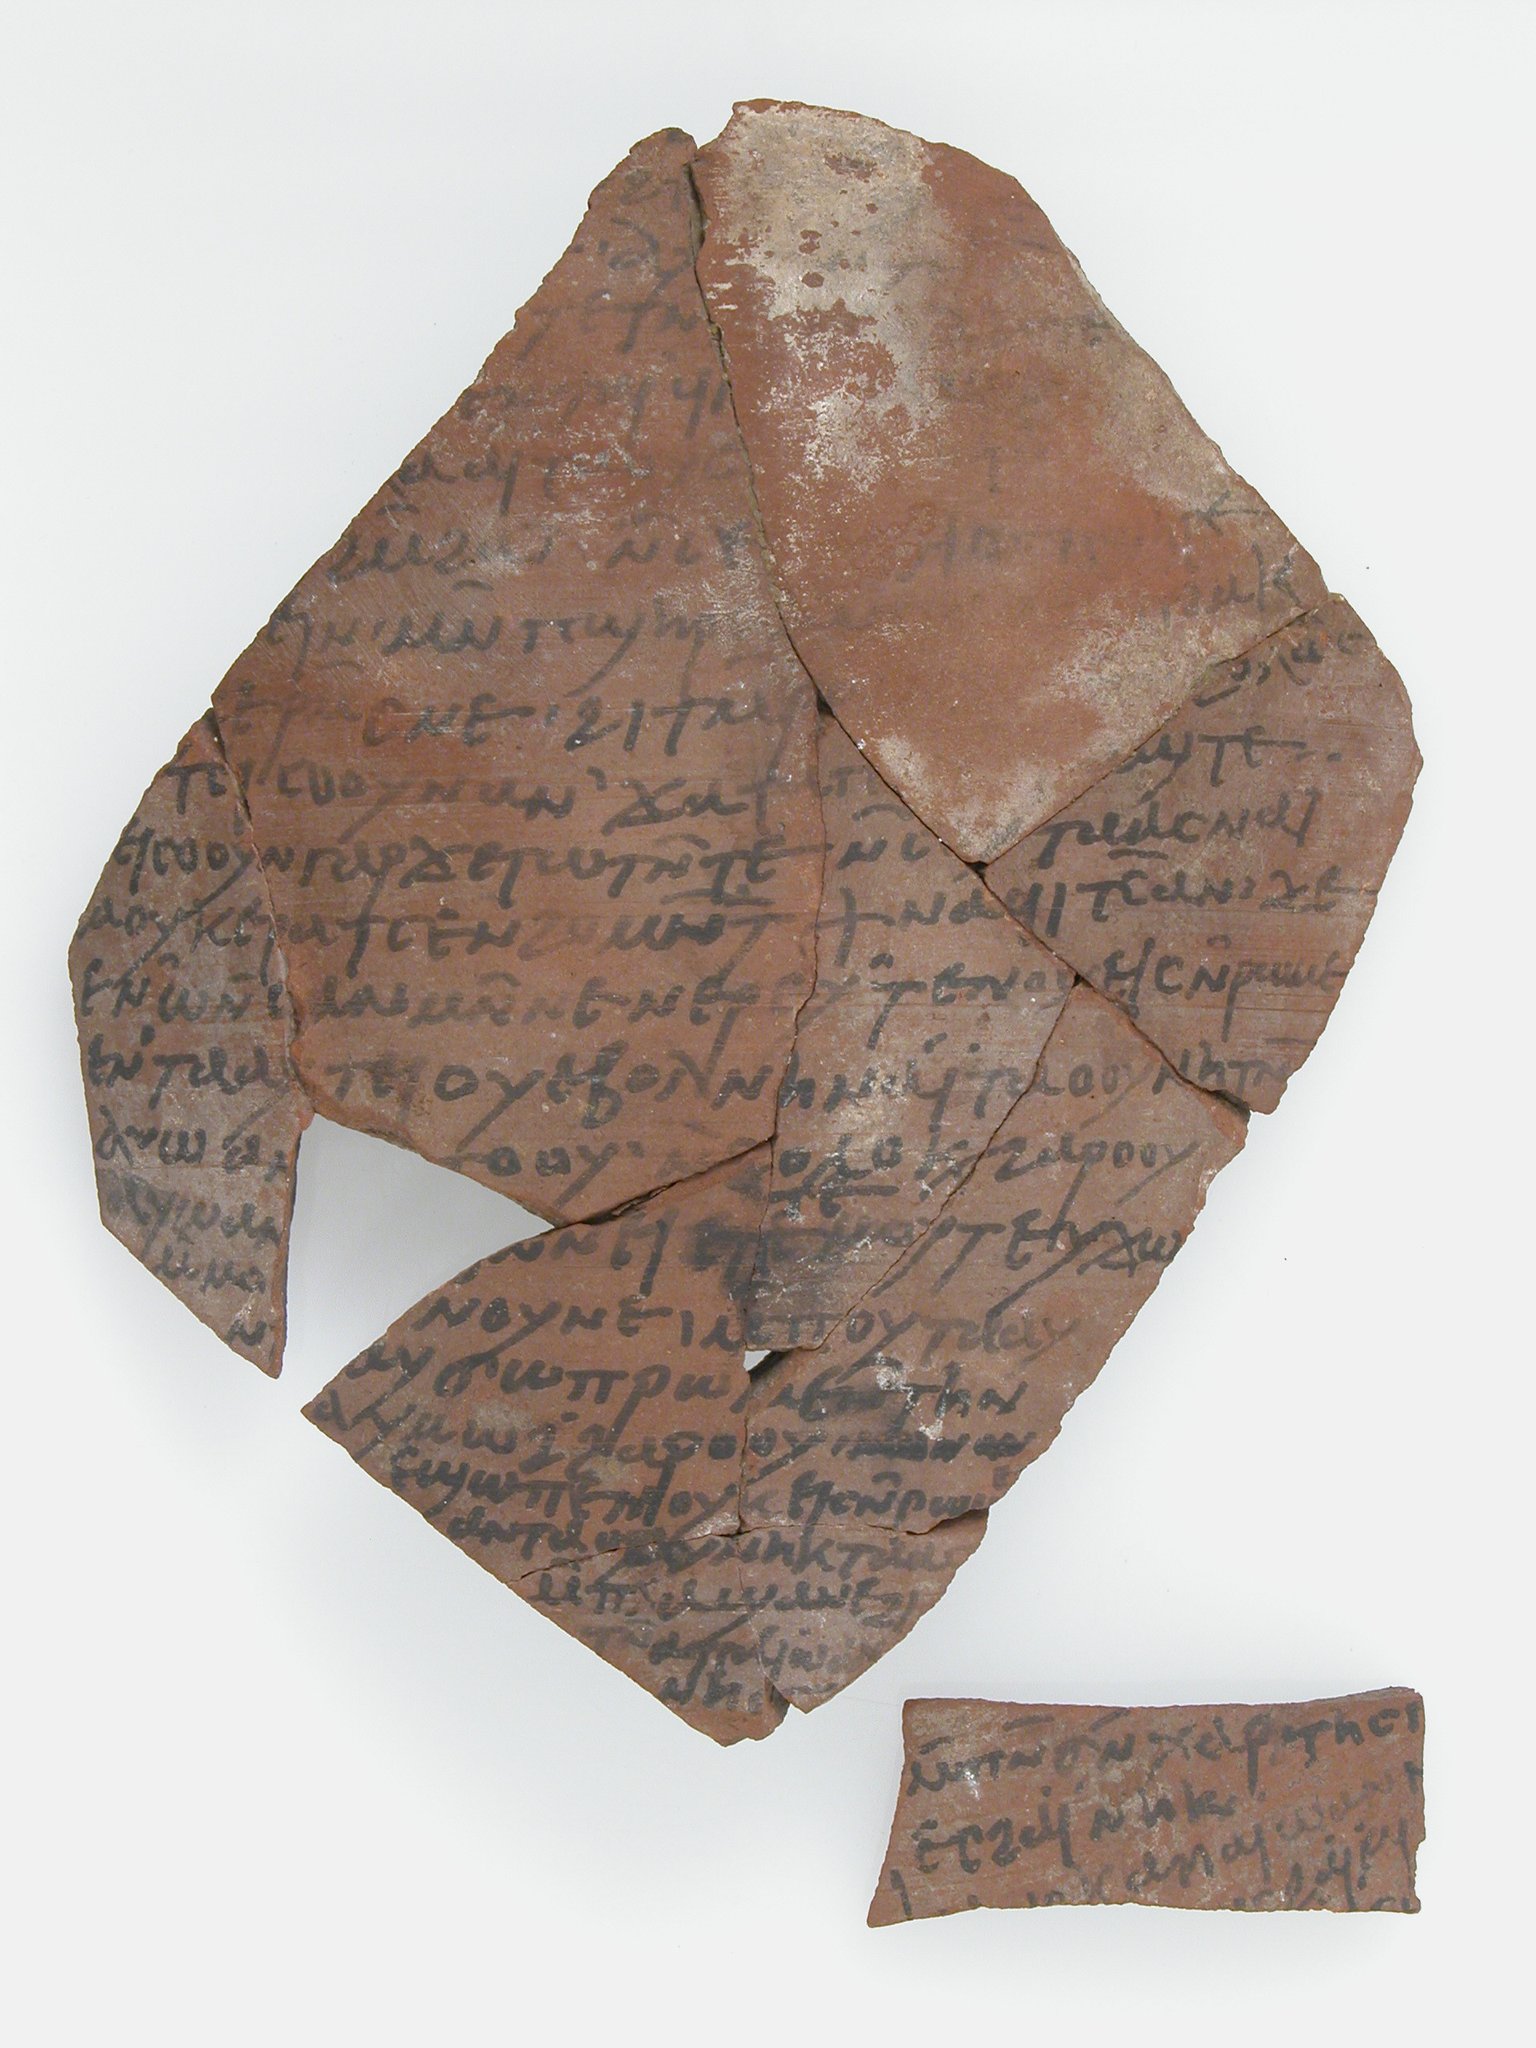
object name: ostrakon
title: Ostrakon with a Letter from John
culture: coptic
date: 600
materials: ink, pottery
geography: egypt